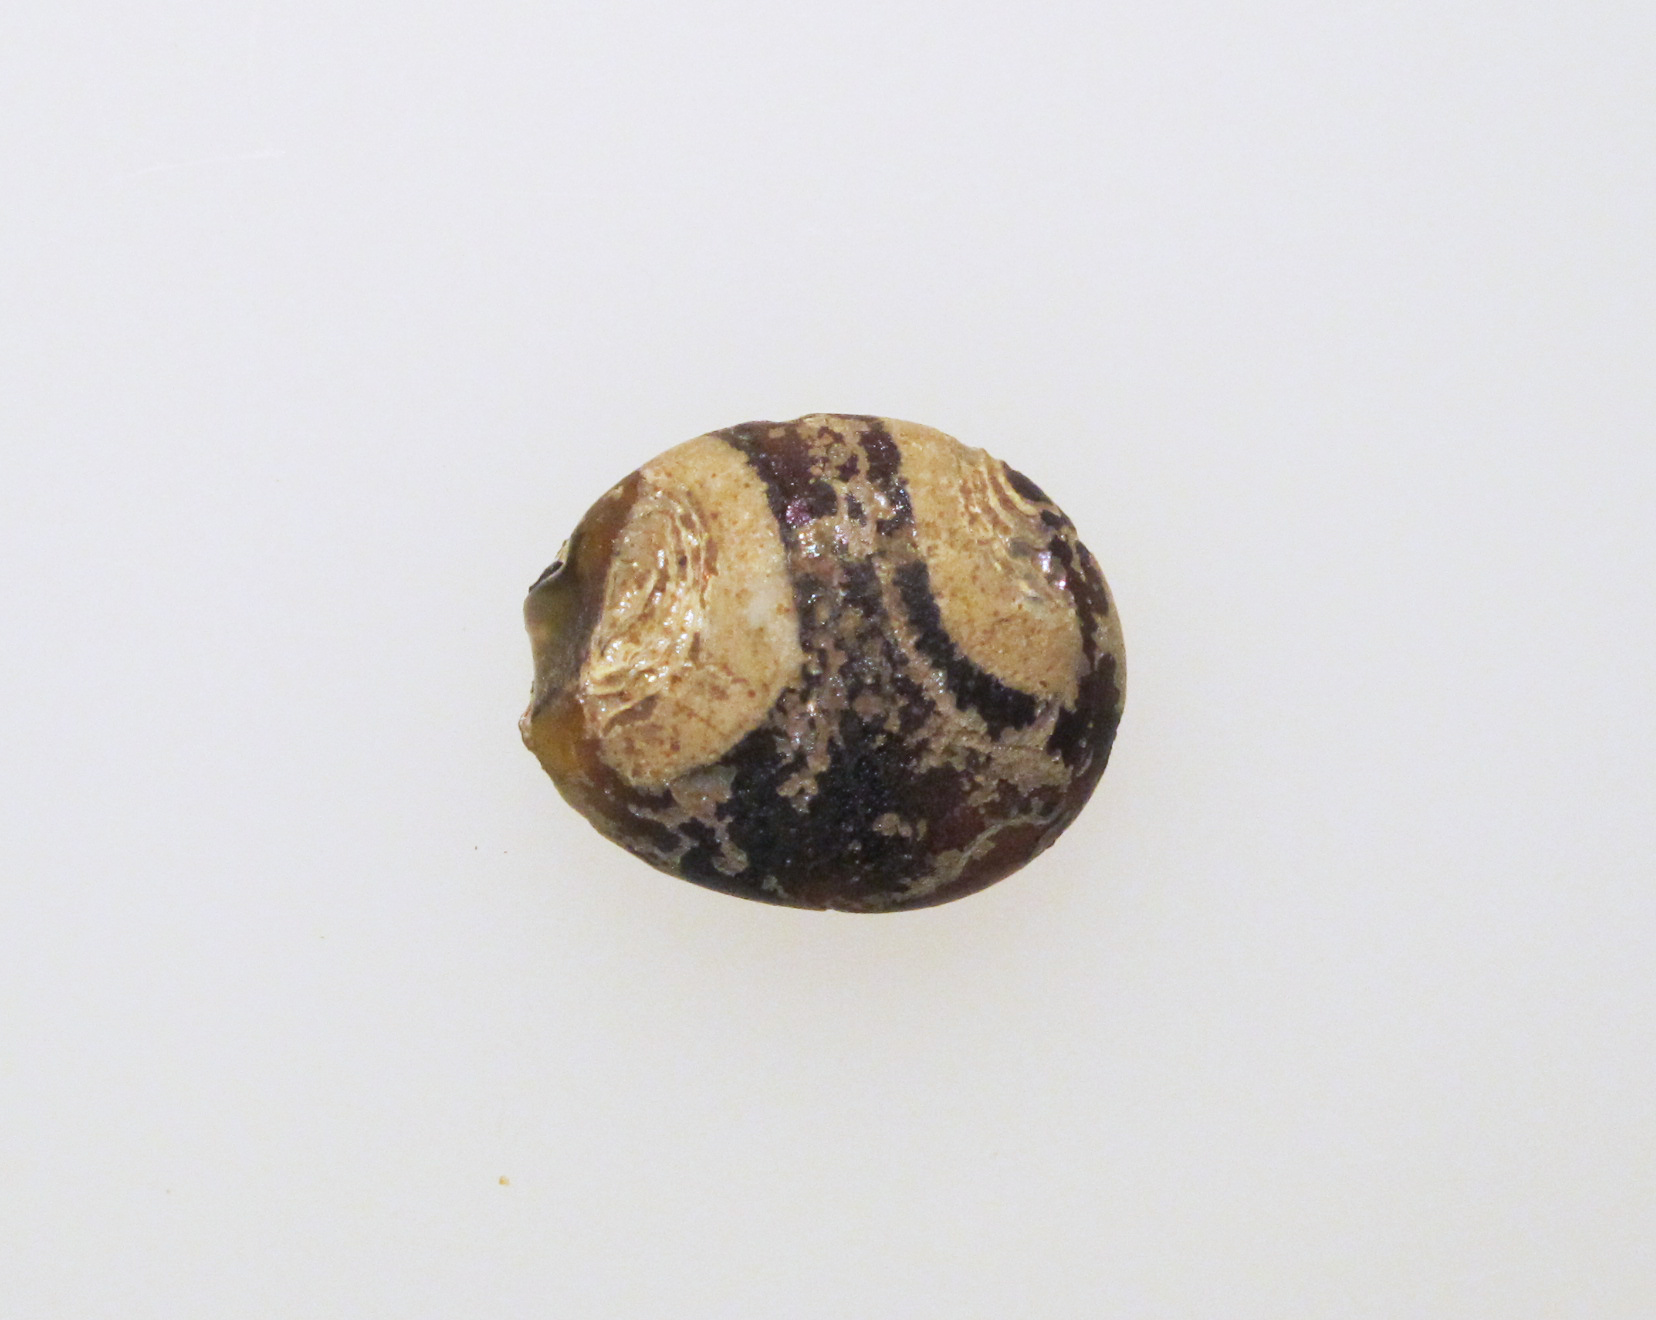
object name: pinhead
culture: roman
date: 670 BCE-330 CE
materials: glass